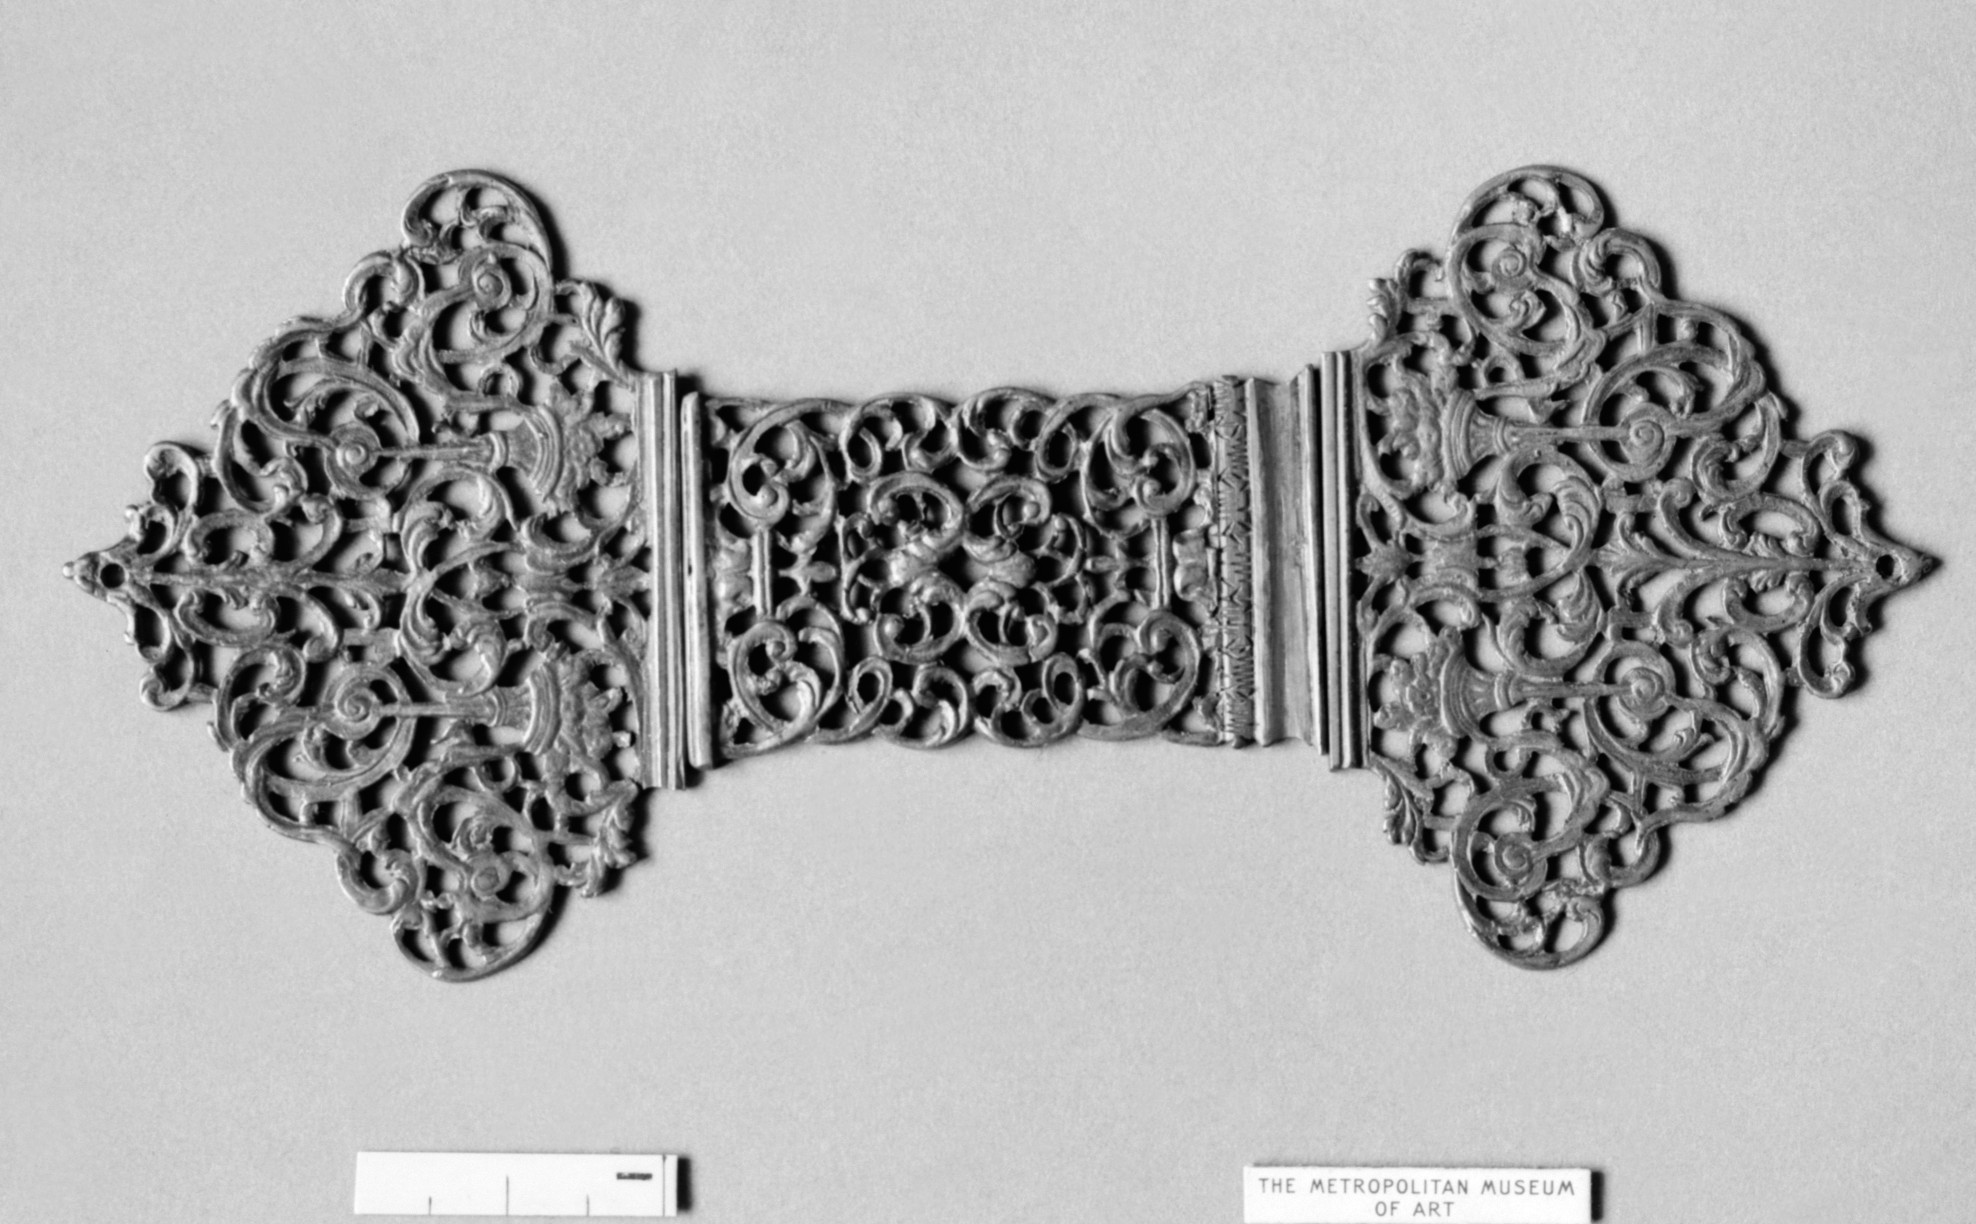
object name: book clasp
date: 1601-1700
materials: silver